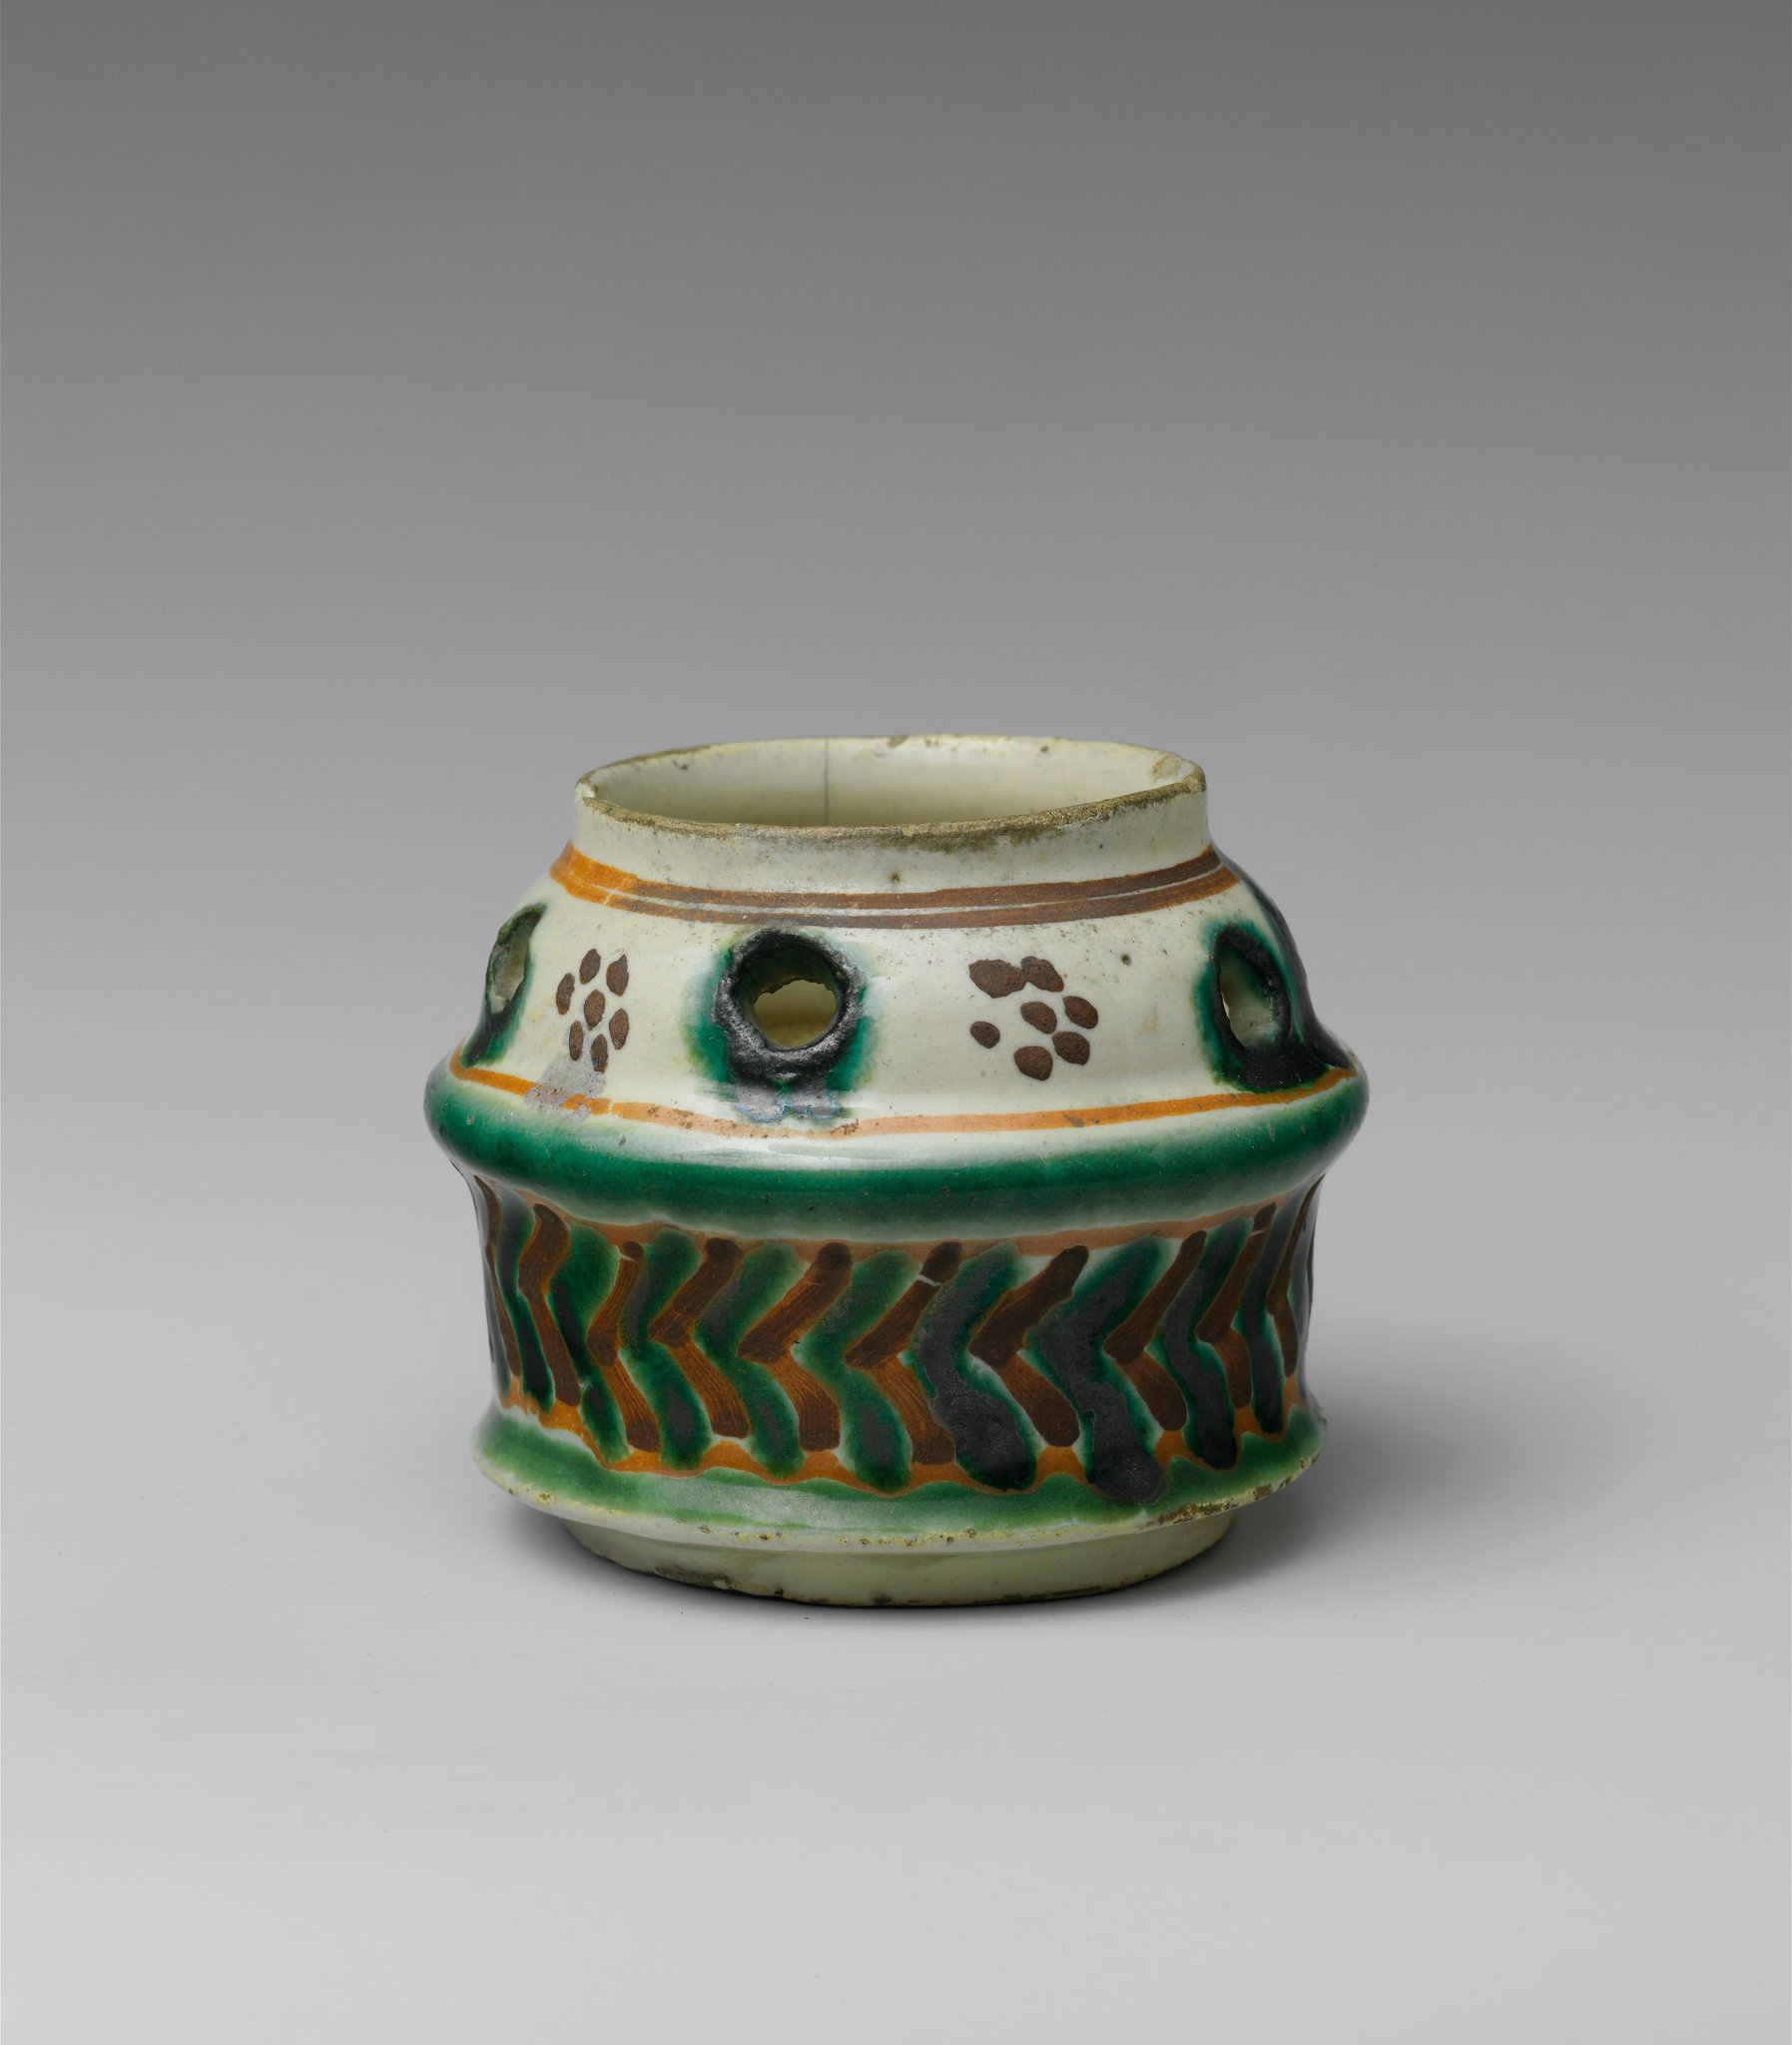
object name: inkwell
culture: mexican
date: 1860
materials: earthenware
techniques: glazing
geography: mexico